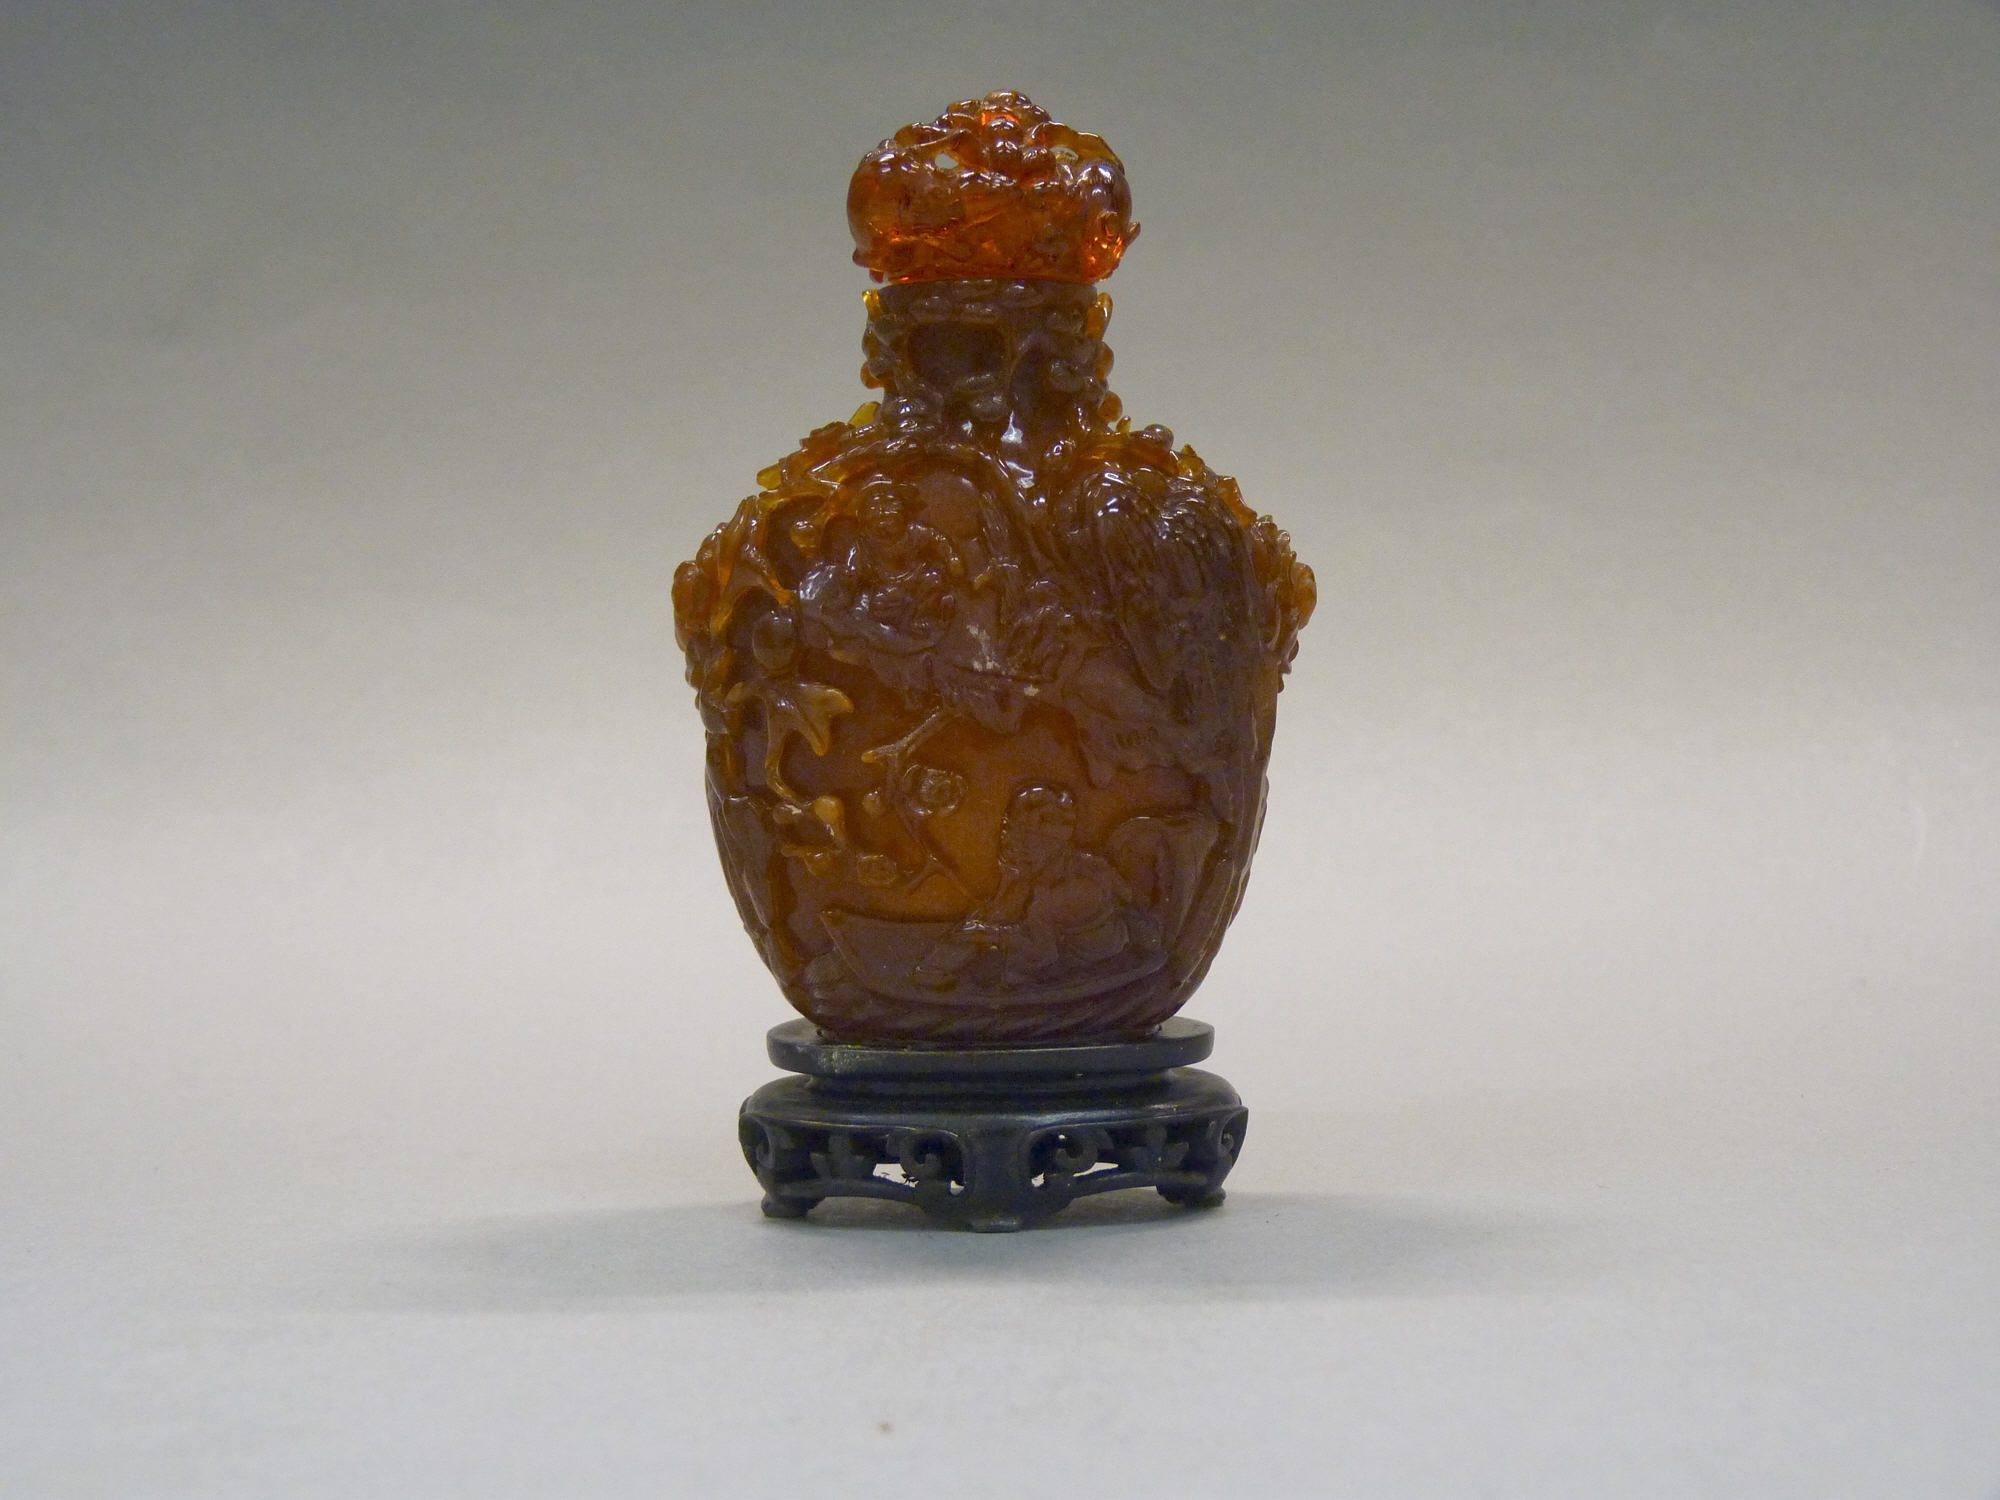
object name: snuff bottle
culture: chinese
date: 1736-1795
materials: amber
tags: human figures,boats